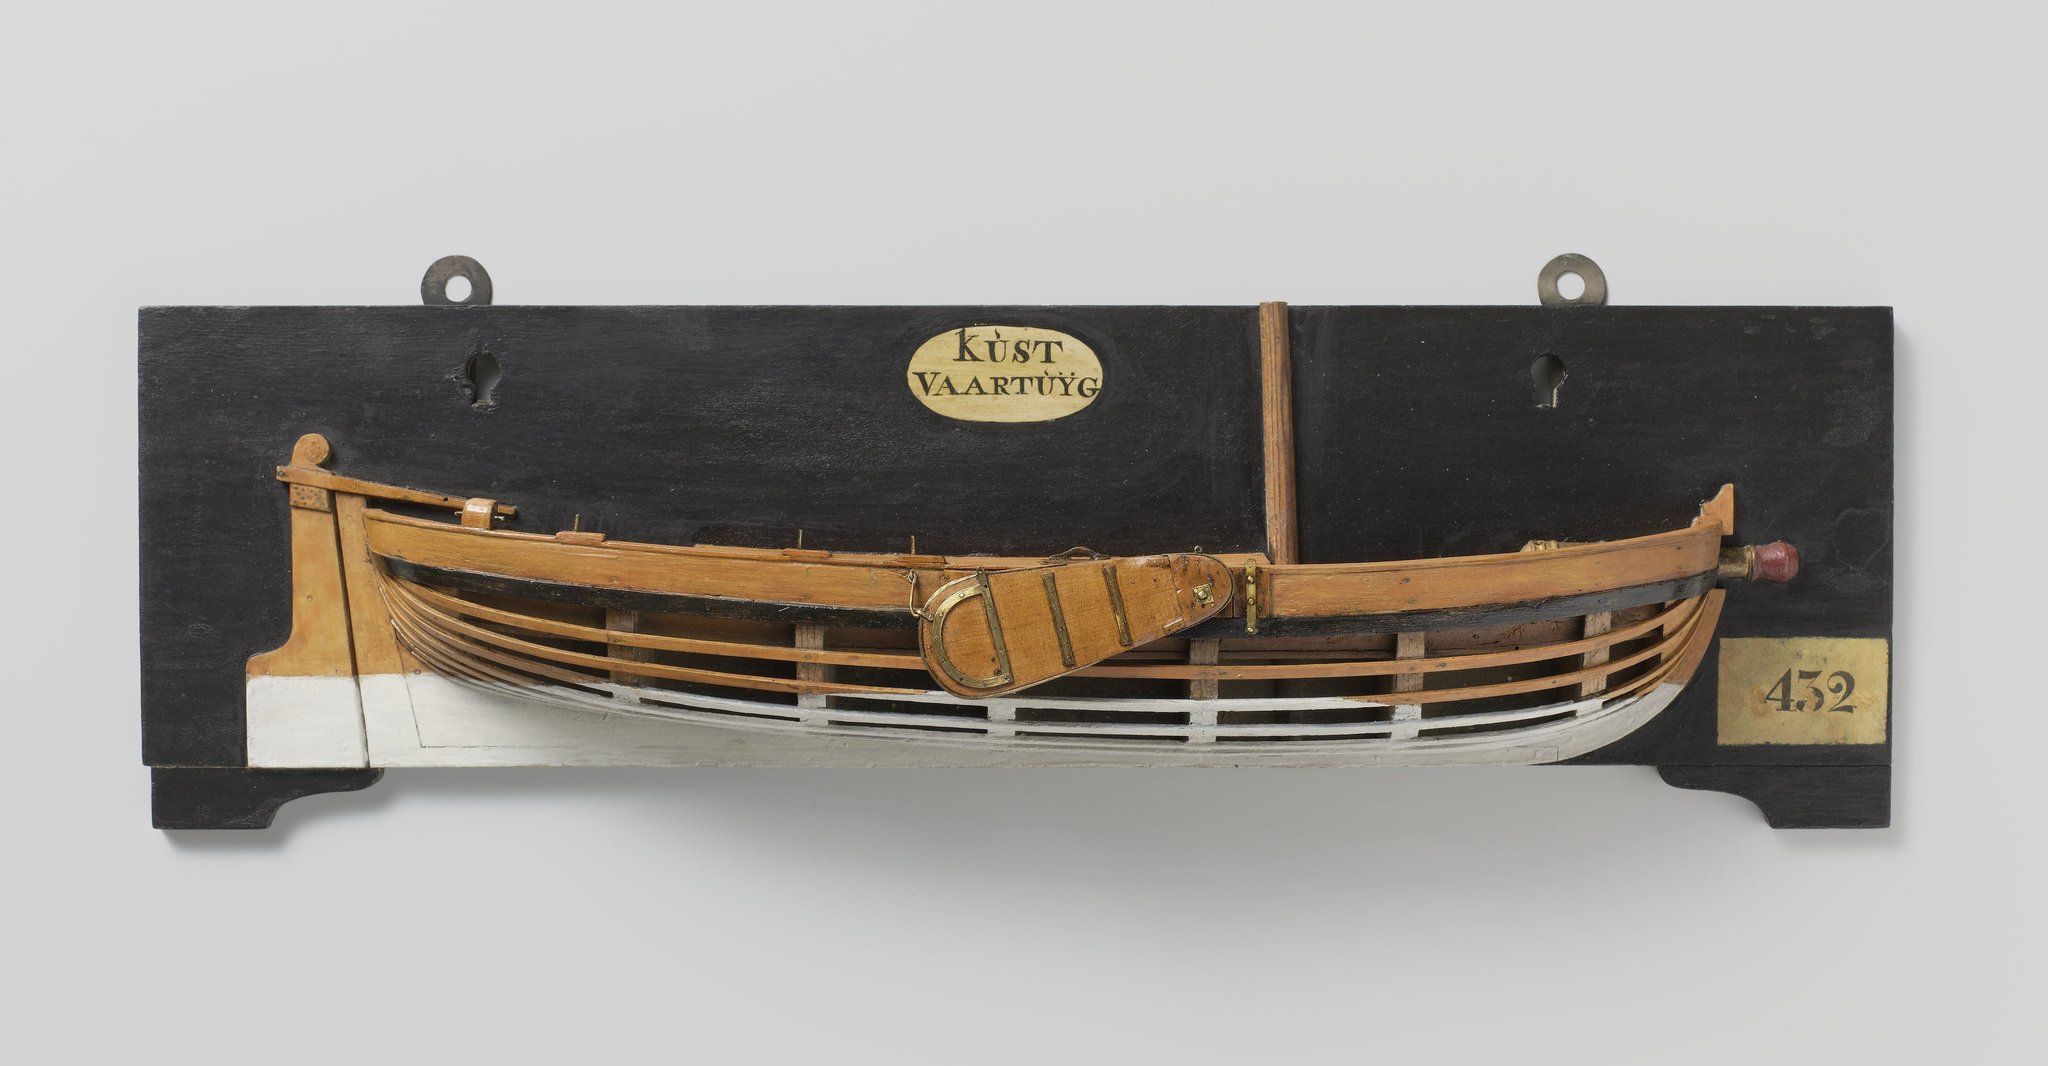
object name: ship model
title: Half Model of a Coastal Vessel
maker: Anonymous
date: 1800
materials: brass, wood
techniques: polychromy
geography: netherlands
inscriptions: label, bottom right: ‘432’ former inventory label, inscription, top centre, on an oval white label: ‘KUST / VAARTUIJG’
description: Gepolychromeerd mallenmodel (stuurboord) van een eenmast platbodem. De huid boven het barkhout is gesloten en draagt een zwaard, een puttingijzer en drie roeidollen. Gesloten dek met een rechthoekig dekhuis in het midden. Rond voorschip met een kanon. Rond achterschip, breed roer met helmstok. De zeeg loopt op naar beide uiteinden, één barkhout.